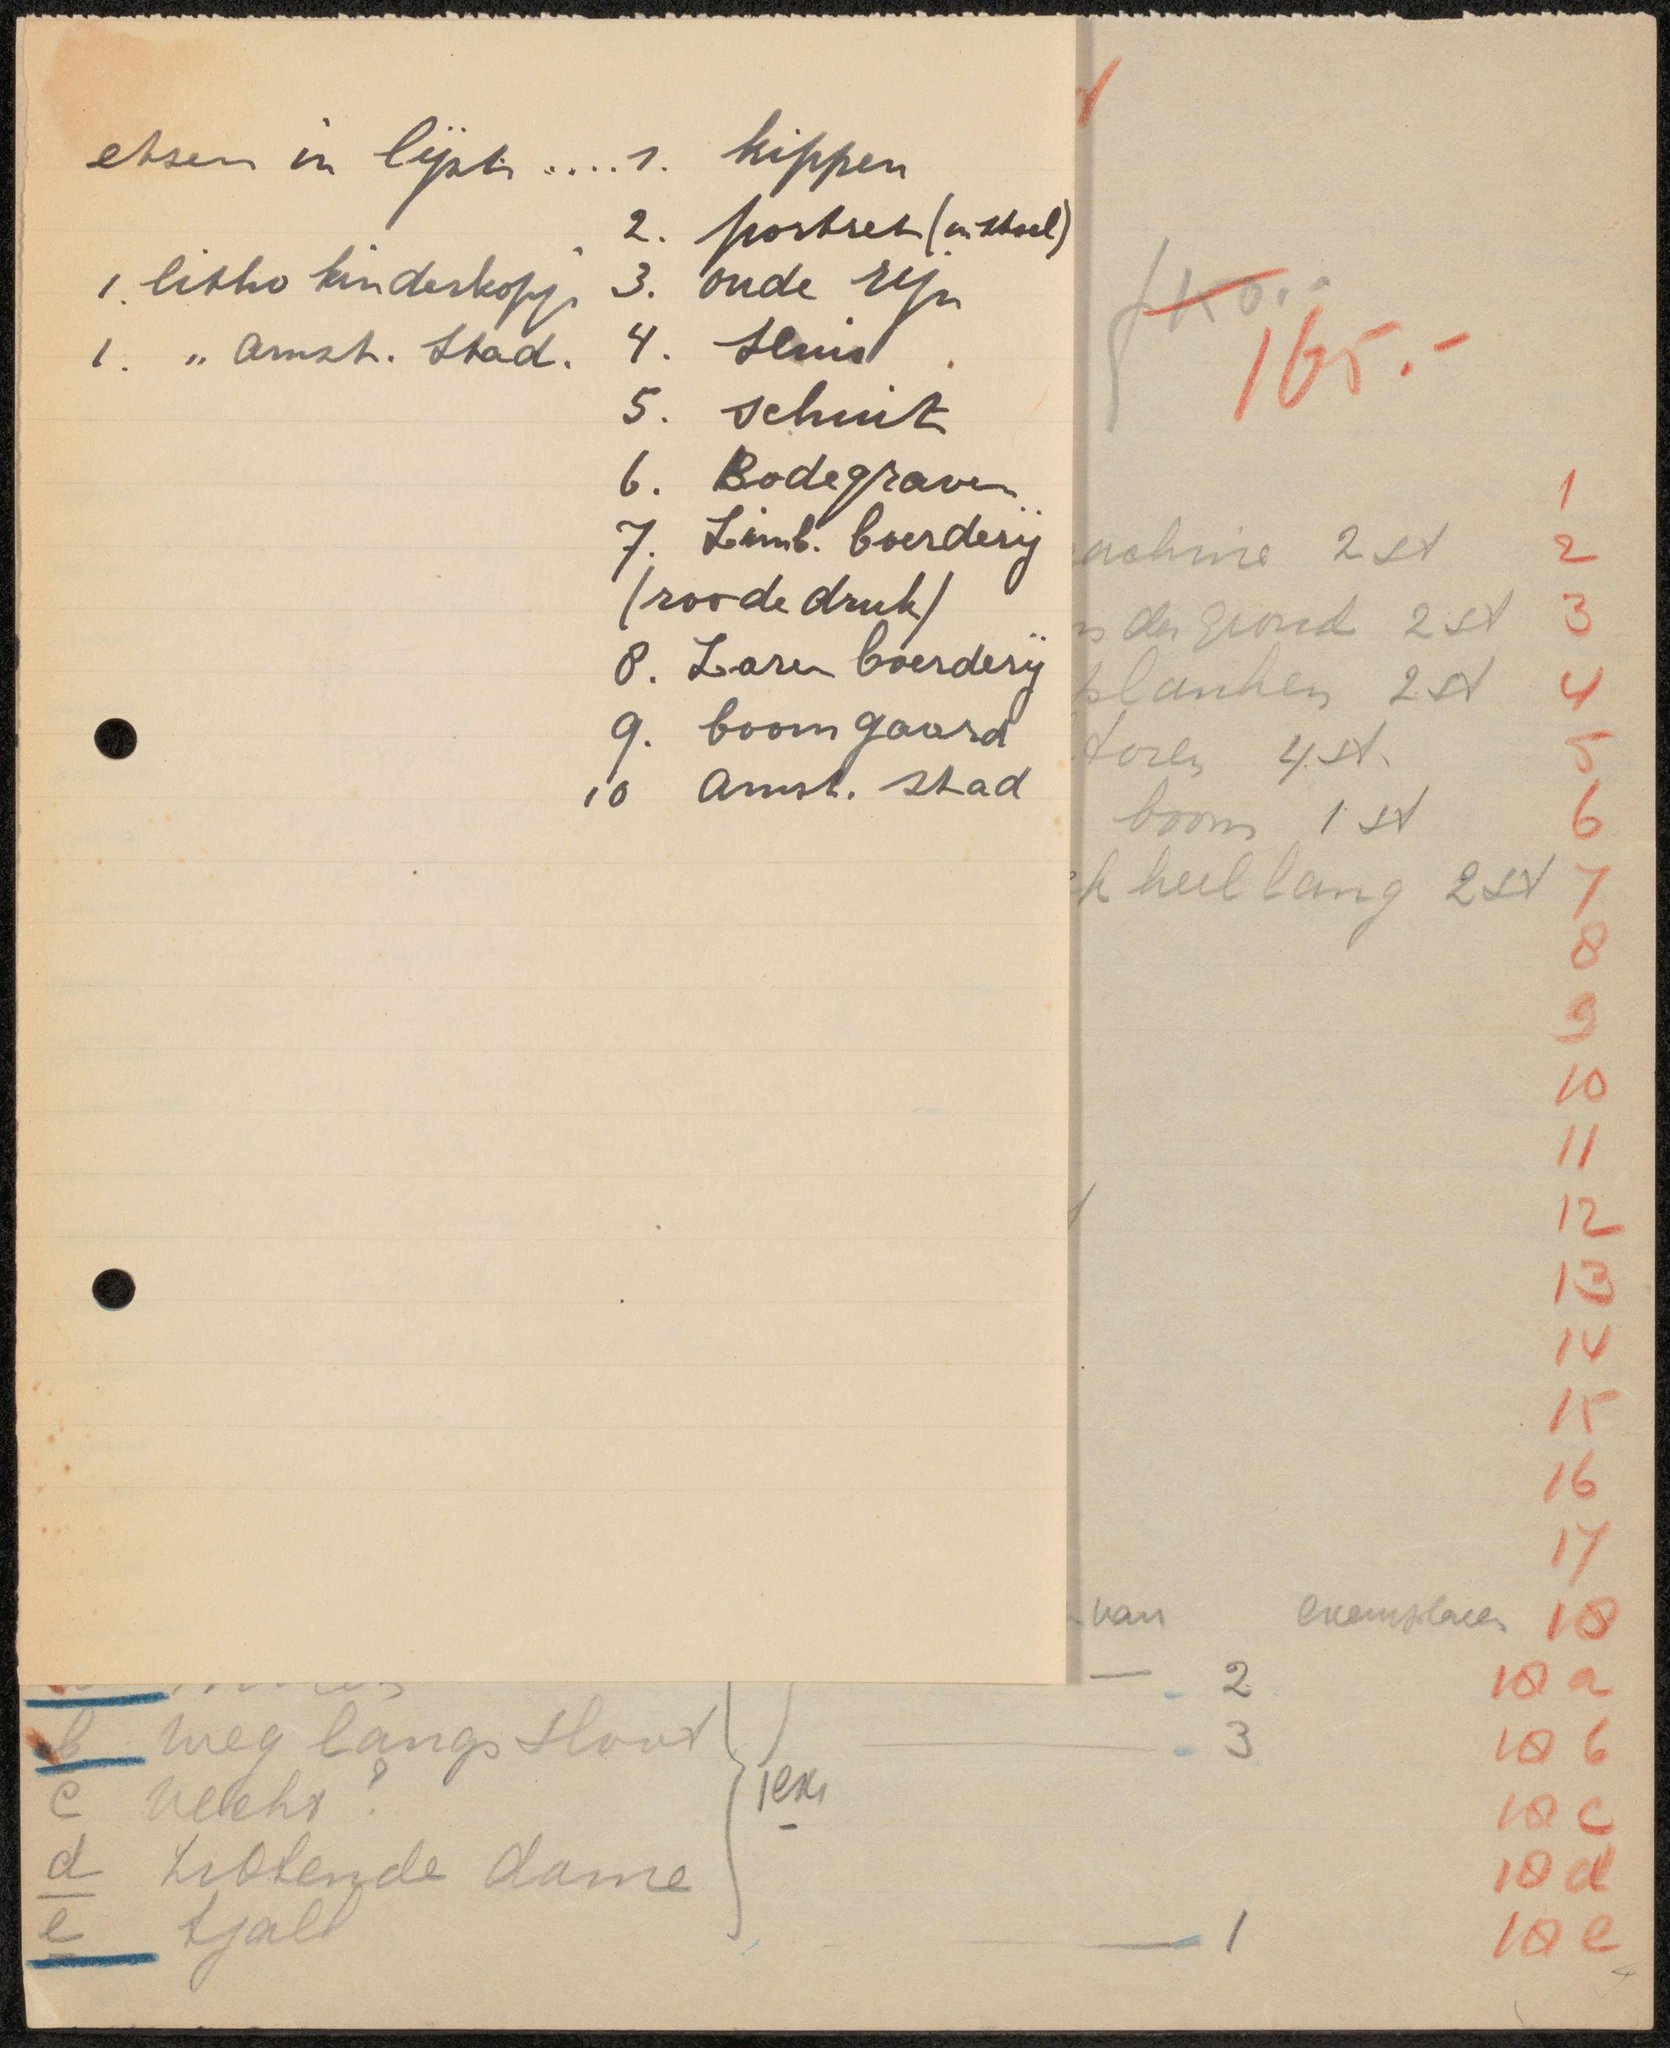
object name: aantekening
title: Aantekening betreffende grafisch werk en tekeningen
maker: Anonymous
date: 1908-1934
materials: ink, pencil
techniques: pen, writing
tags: drawing, the graphic arts, money